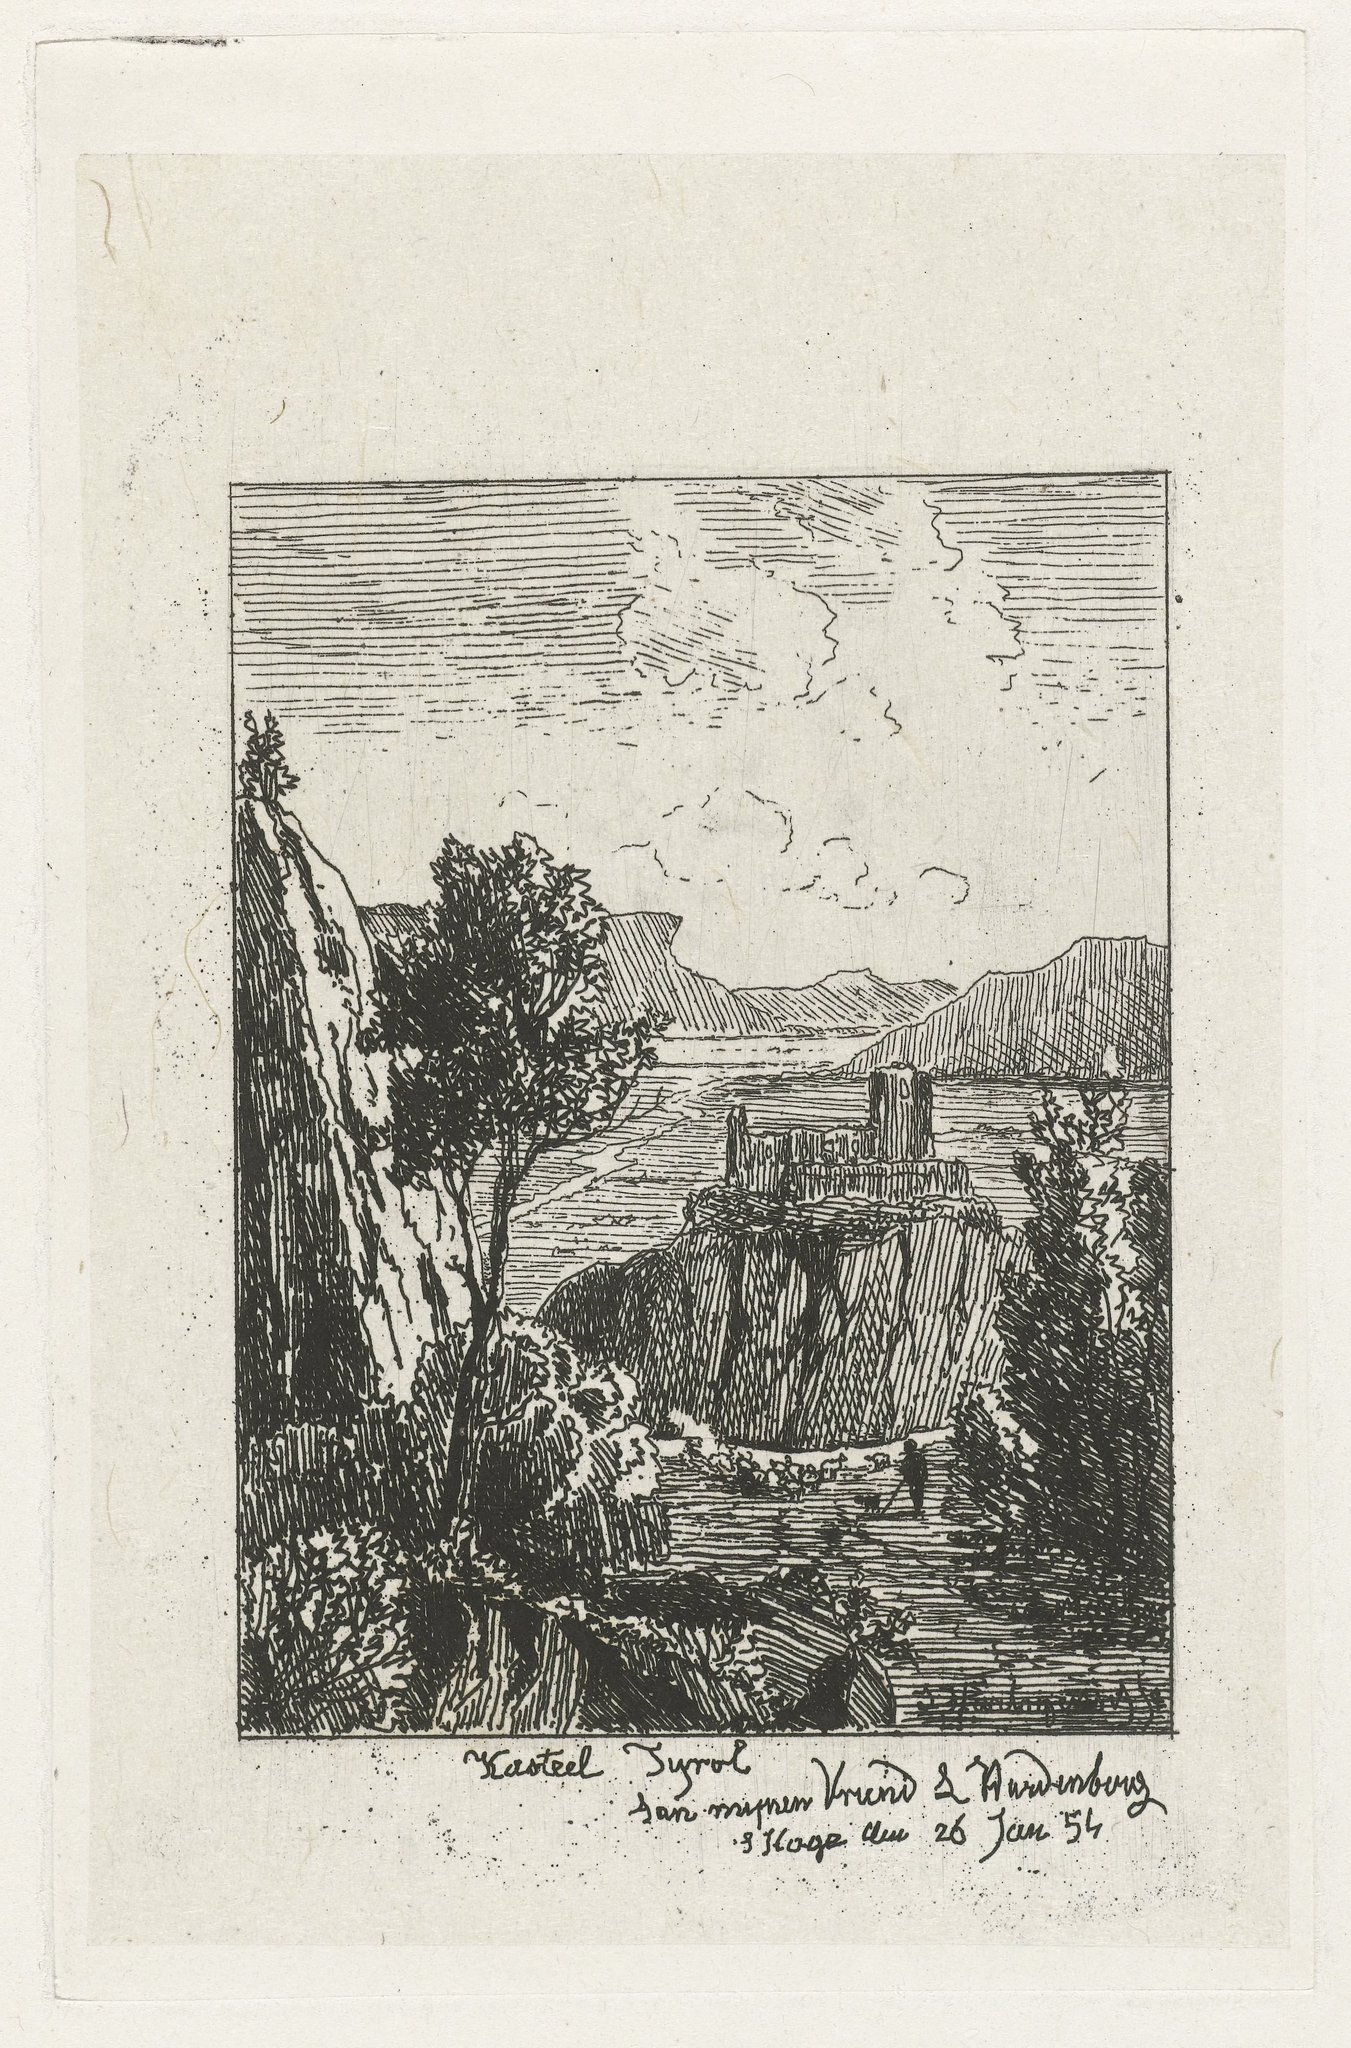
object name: print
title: Kasteel in Tyrol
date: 1854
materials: paper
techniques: etching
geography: the hague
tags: castle, rocks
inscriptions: collector's mark: Lugt 2228